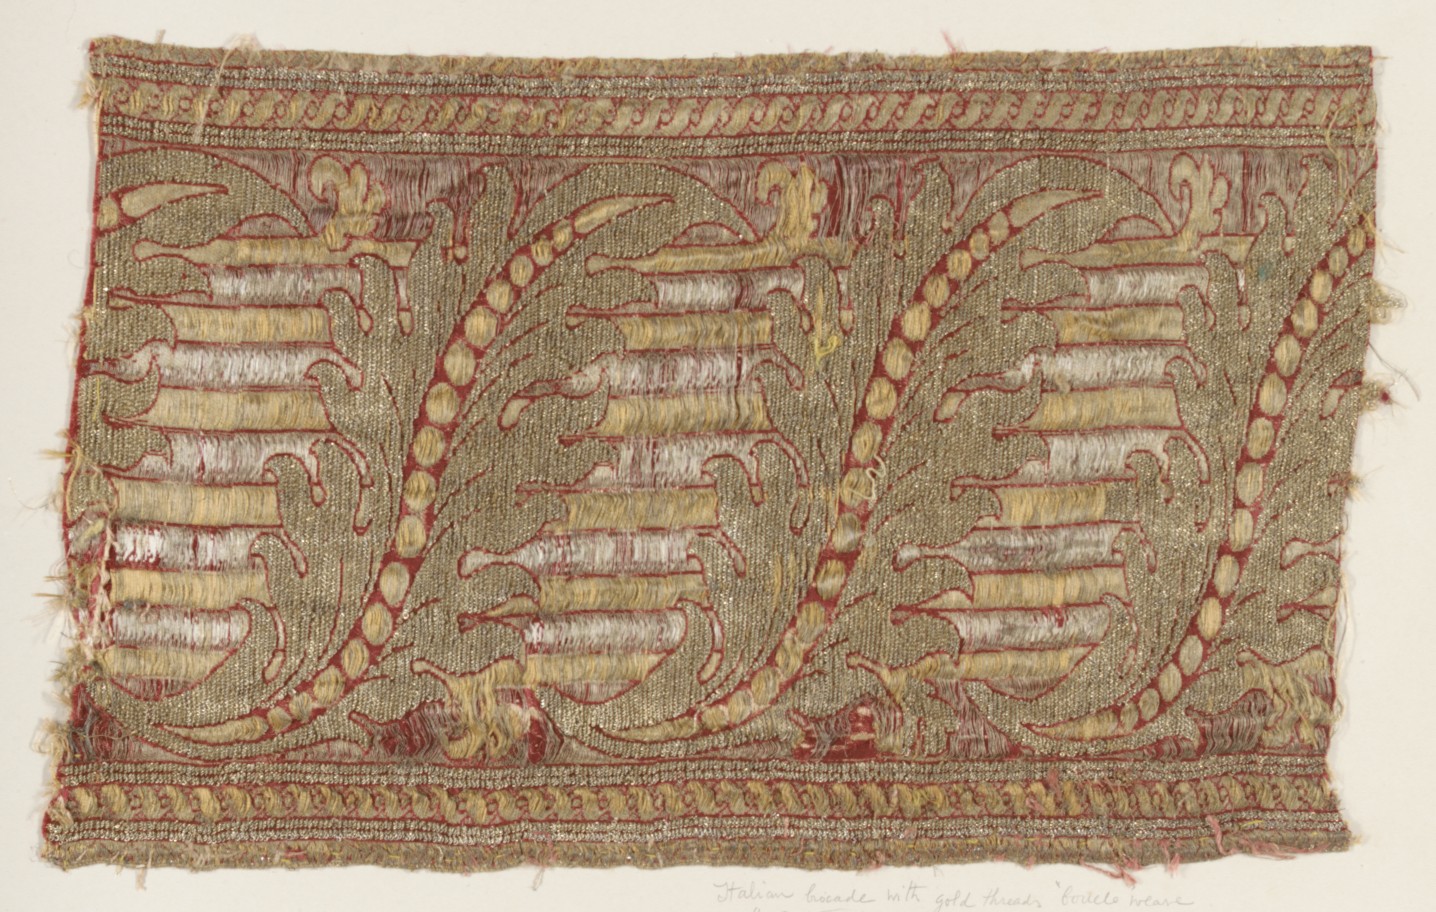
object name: fragment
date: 1501-1600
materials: metal thread, silk